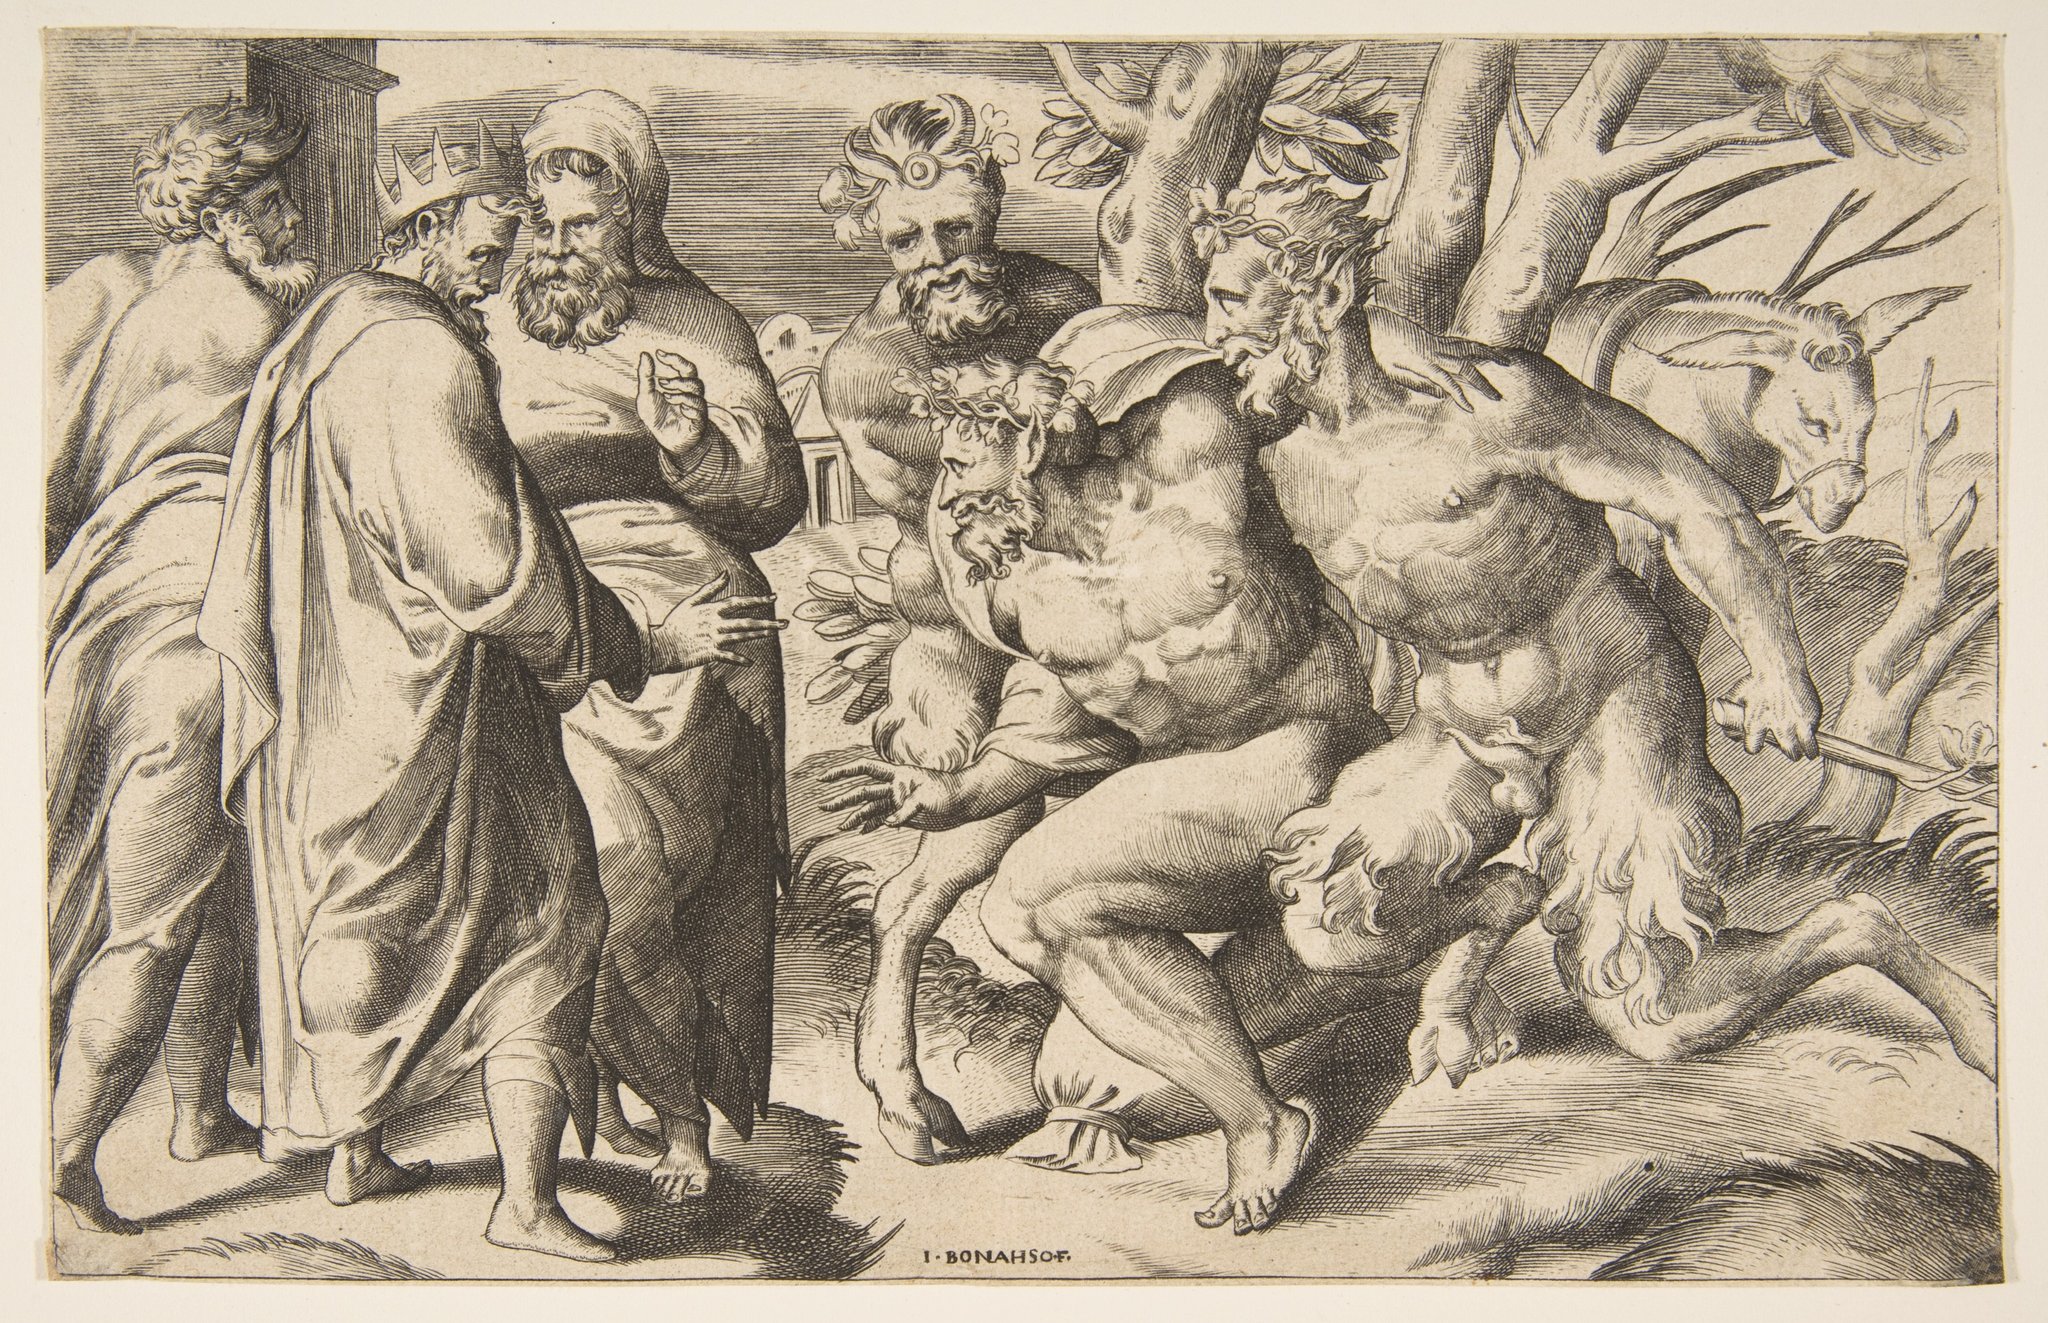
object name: print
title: Two satyrs brining Silenus King Midas standing at the left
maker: giulio bonasone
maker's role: artist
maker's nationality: italian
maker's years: 1510-1576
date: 1531-1576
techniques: engraving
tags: men,midas,satyrs